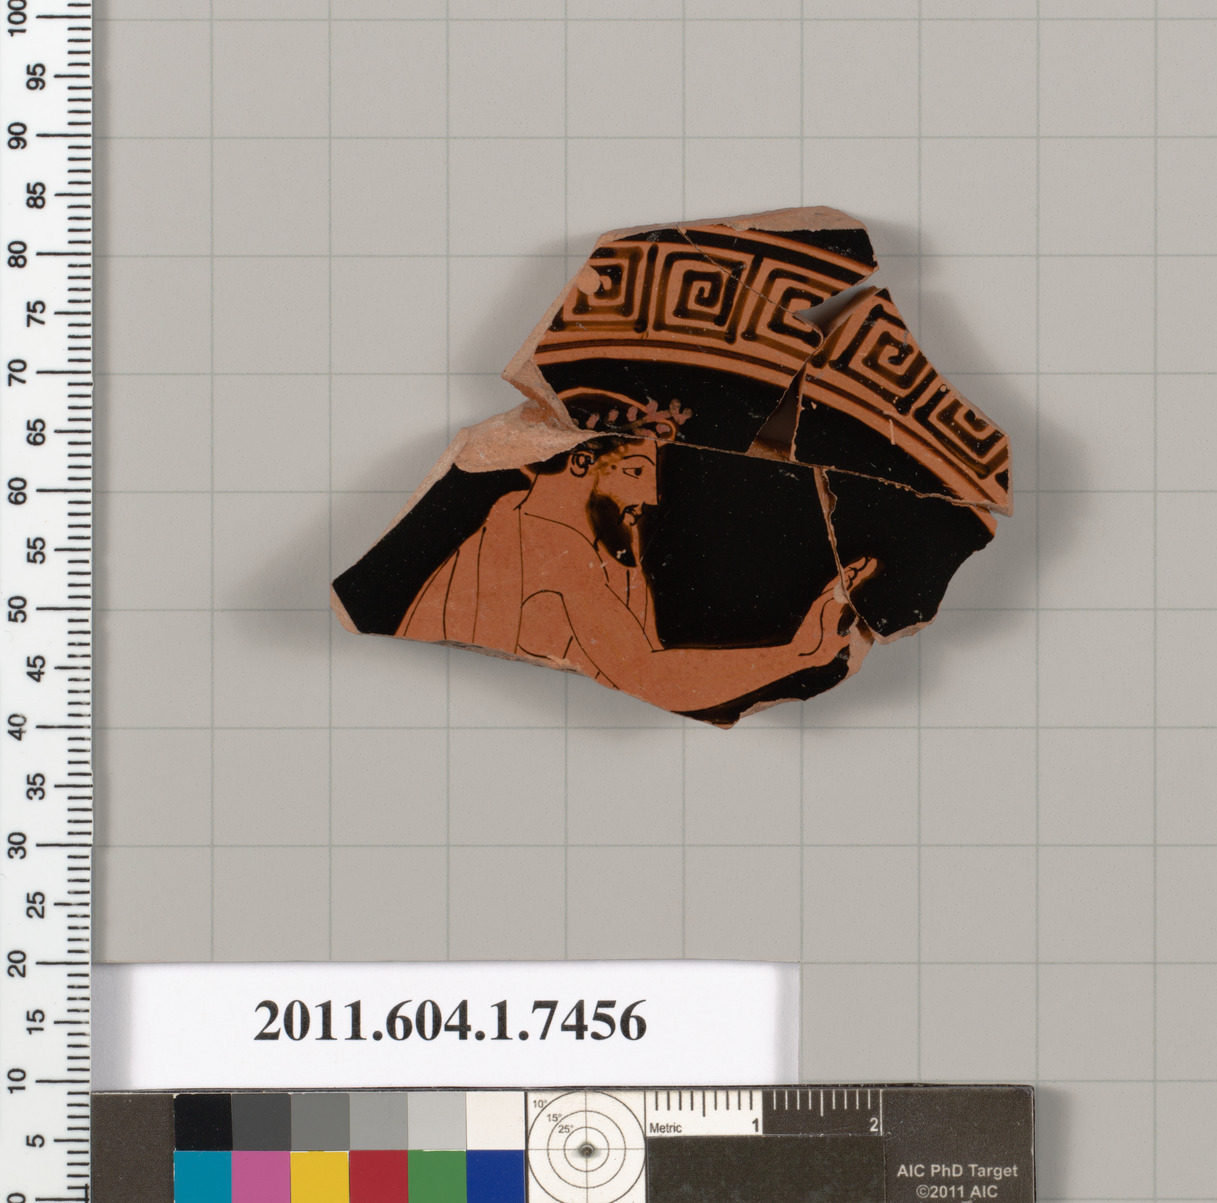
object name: kylix fragment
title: Terracotta fragment of a kylix (drinking cup)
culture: greek, attic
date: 470-460 BCE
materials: terracotta